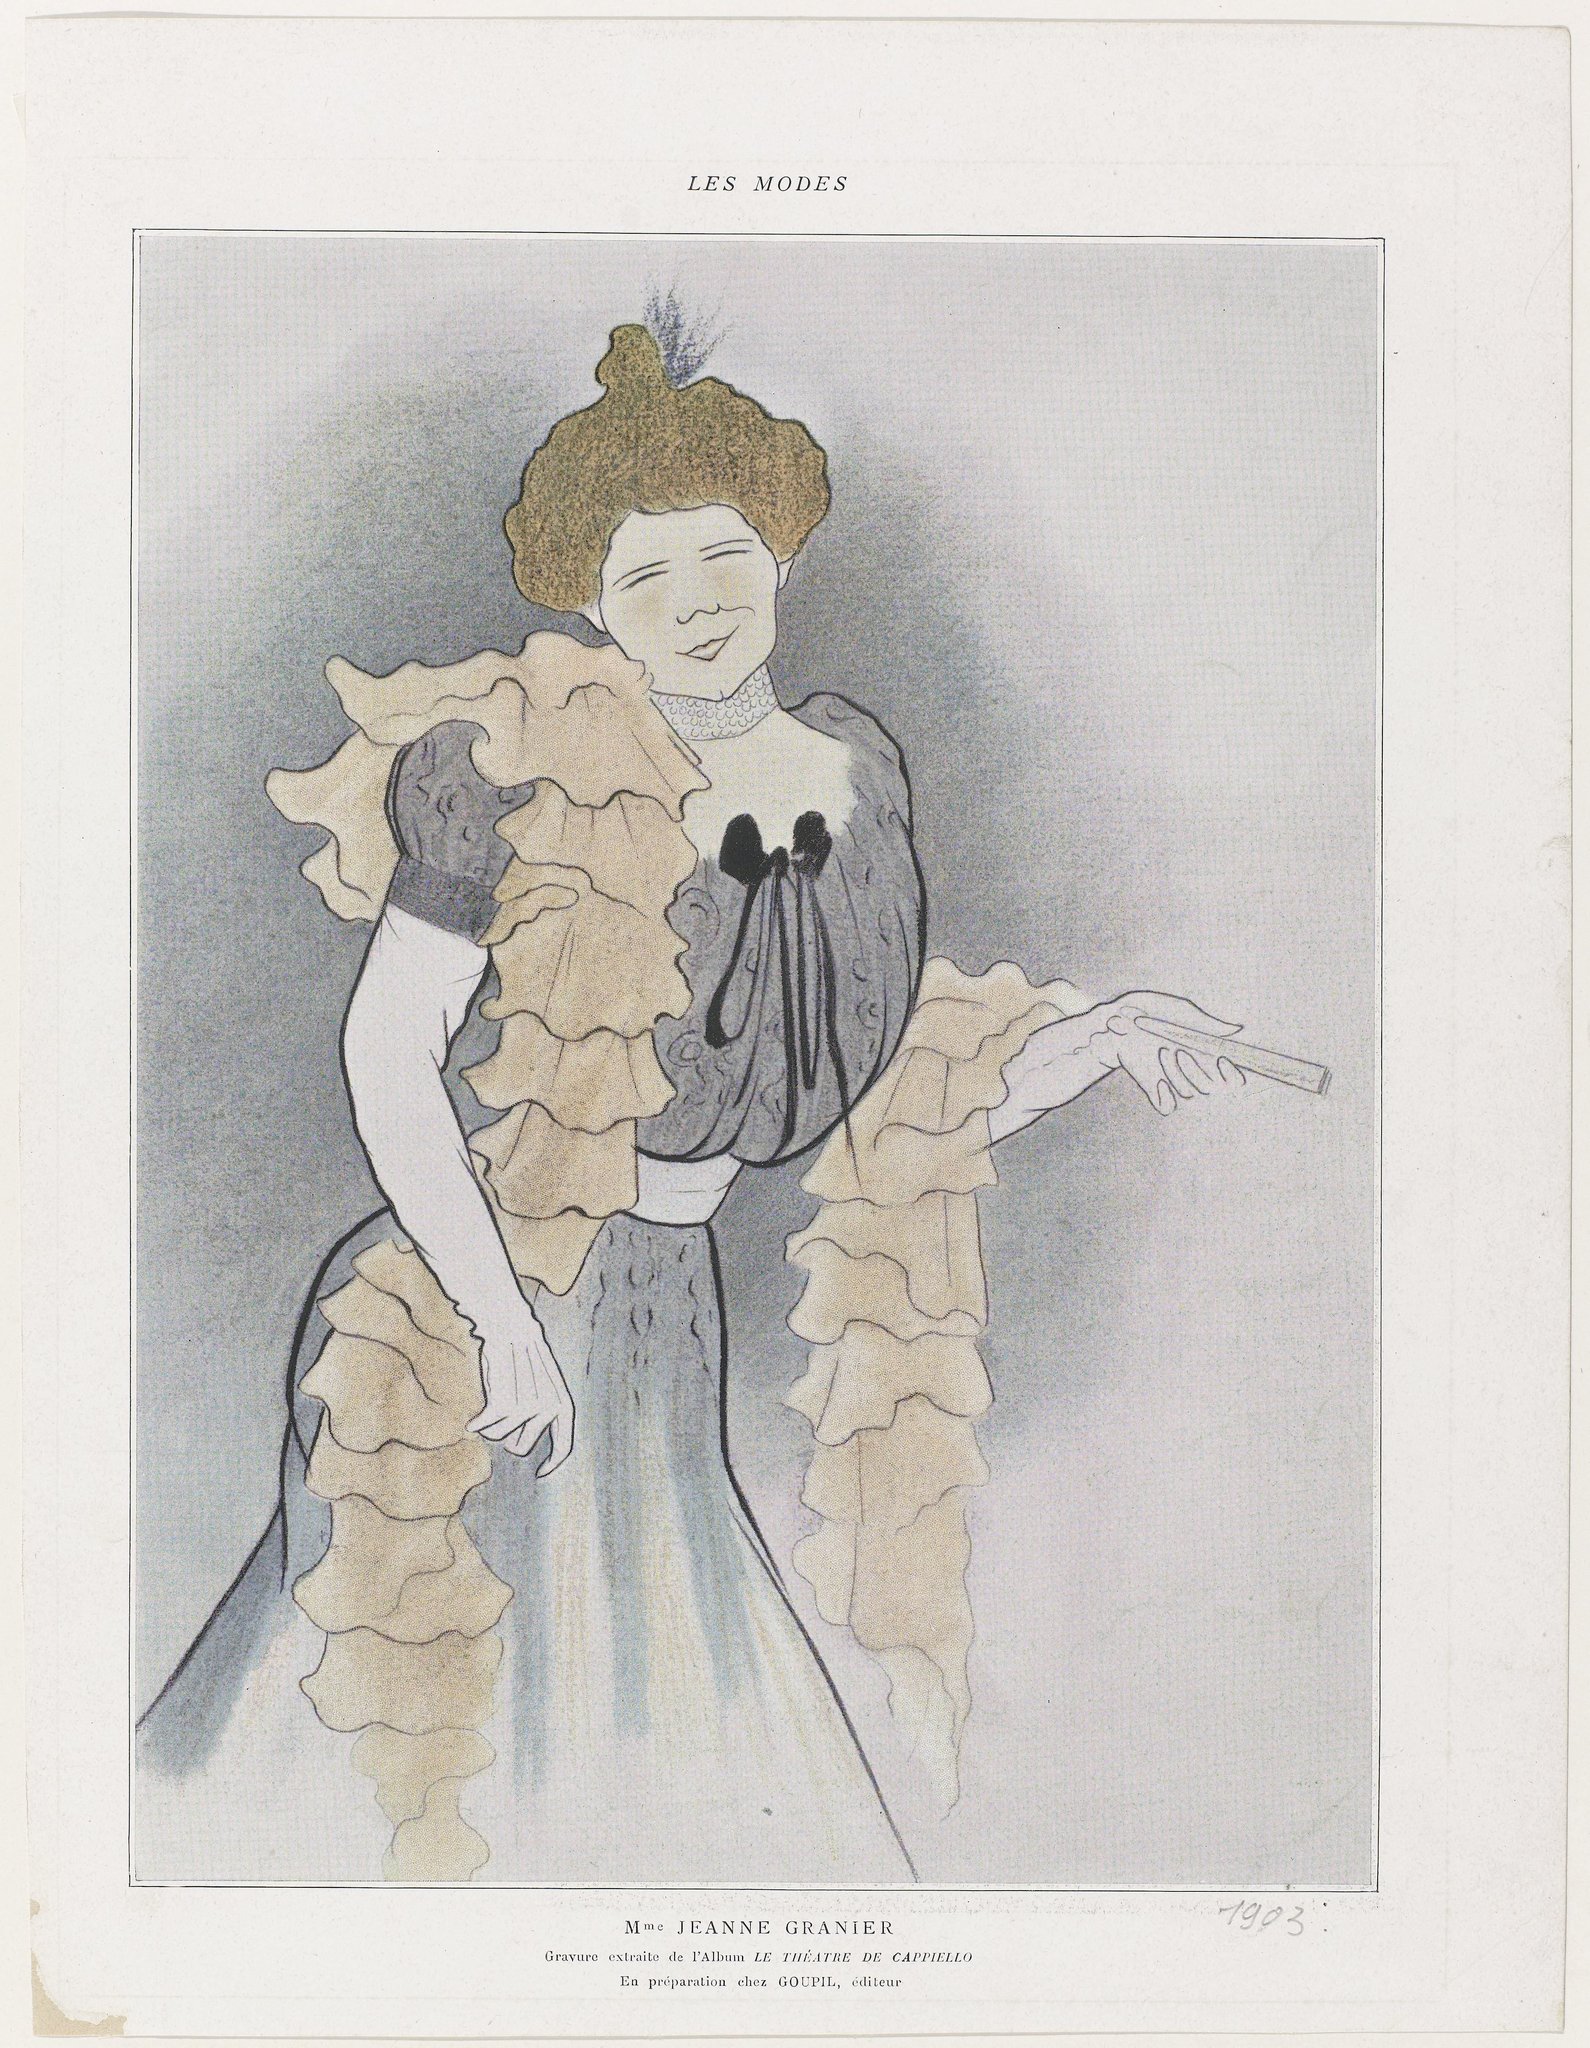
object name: fashion print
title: Les Modes, 1903 : Mme Jeanne Granier (...)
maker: Anonymous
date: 1903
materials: paper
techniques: printing, photochemical processes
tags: bow (ornamental part of clothing) (+ women's clothes), clothing for the upper part of the body (shawl) (+ women's clothes), fashion plates, dress, gown (+ women's clothes), fan (+ women's clothes)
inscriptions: title: ‘LES MODES’, caption: ‘Mme JEANNE GRANIER / Gravure extraite de L'Album LE THÉATRE DE CAPPIELLO / En préparation chez GOUPIL, éditeur’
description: Jeanne Granier in een japon met korte pofmouwen en bij de ronde hals een strik. Om de schouders een sjaal bestaande uit geplooide stroken(?). Verdere accessoires: collier, lange handschoenen, ceintuur(?) en waaier. Reproductie naar een gravure uit het album van 'Le Théatre de Cappiello'. Prent uit het modetijdschrift Les Modes (1901-1937).